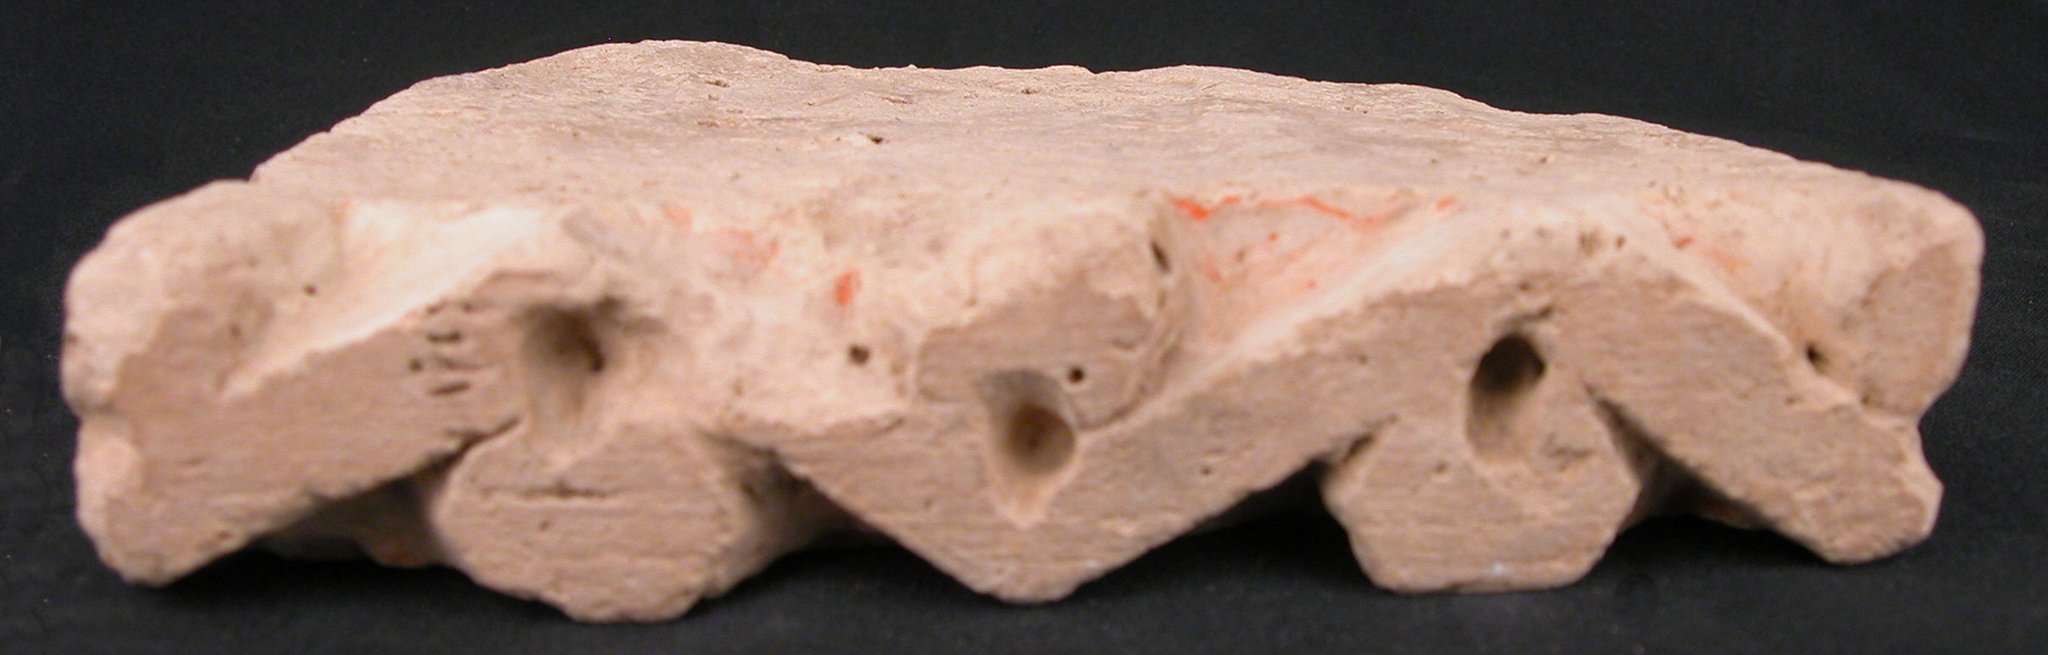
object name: frieze fragment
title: Fragment of a Frieze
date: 1001-1100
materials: earthenware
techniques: carving, painting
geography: iran